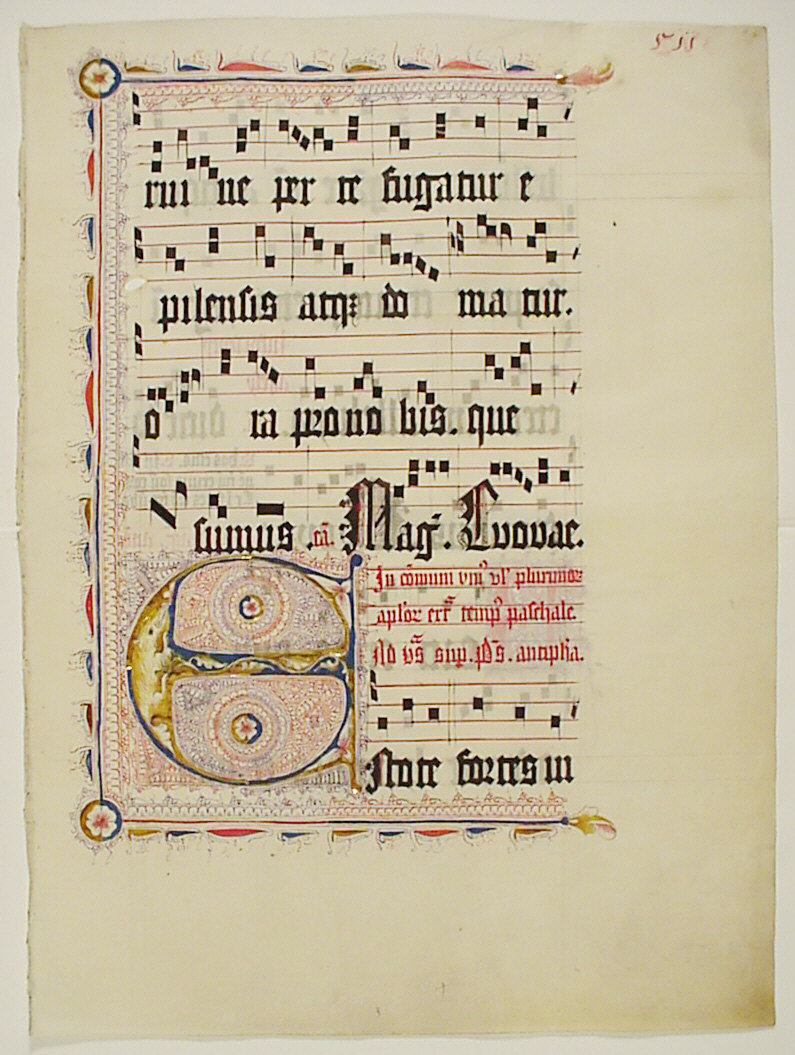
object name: antiphonary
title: Manuscript Leaf with Initial E, from an Antiphonary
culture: german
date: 1426-1450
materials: ink, metal leaf, parchment, paint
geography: germany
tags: music